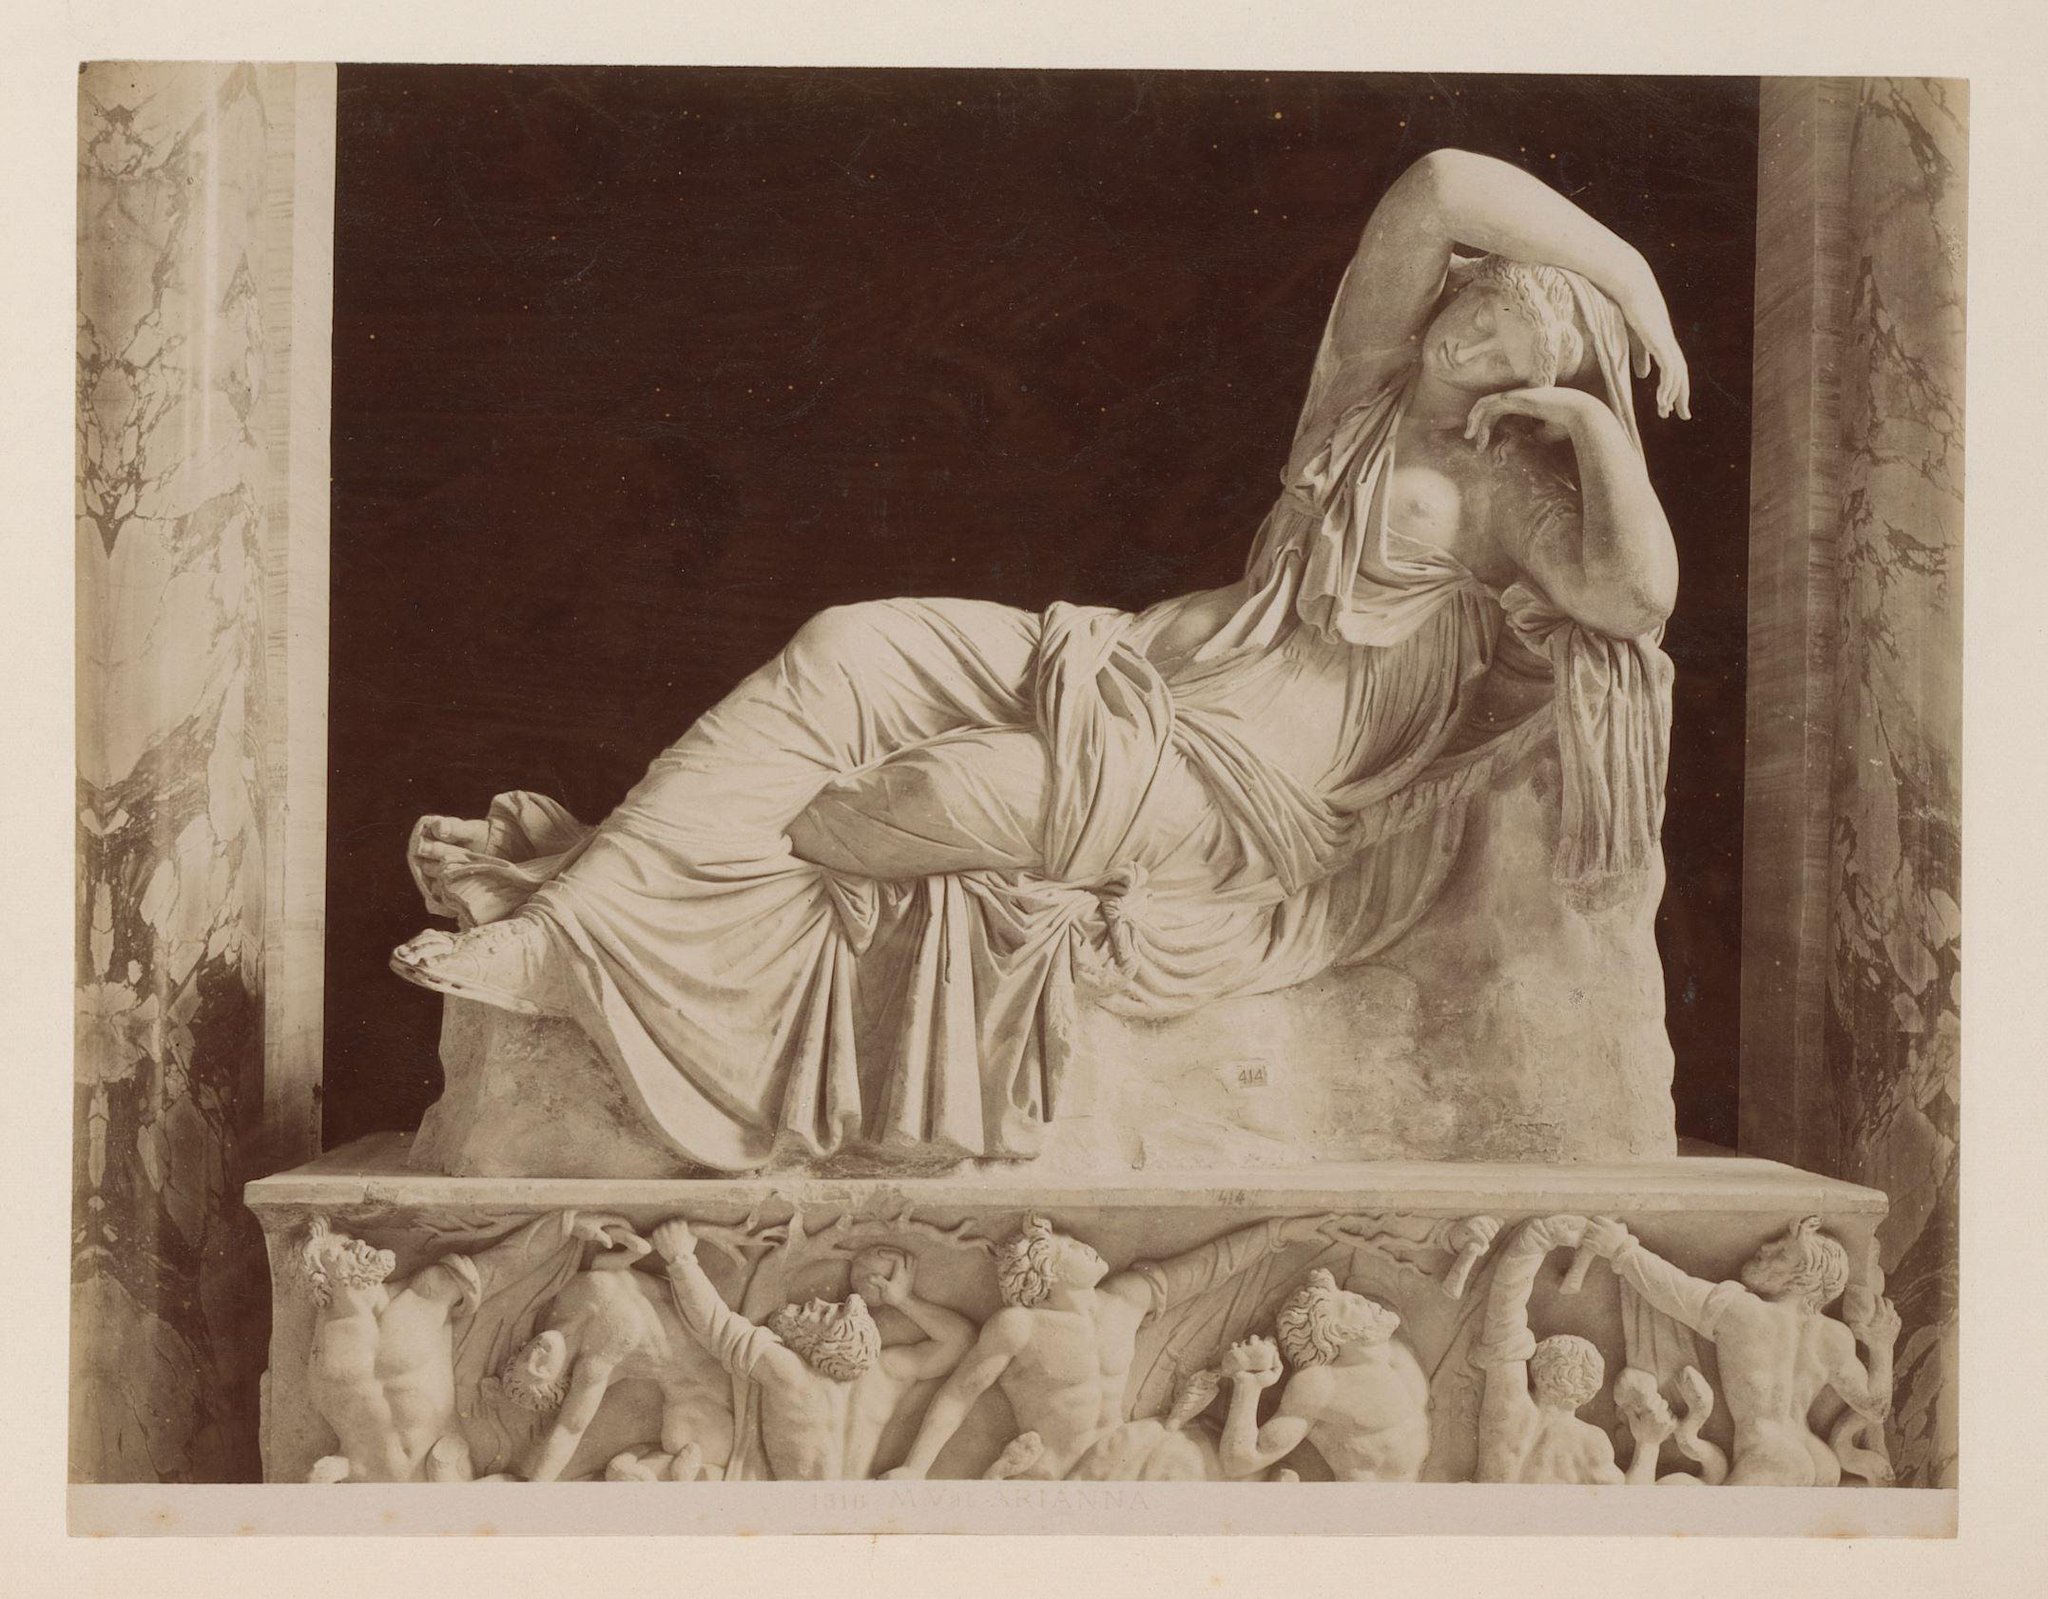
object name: album leaf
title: Sculptuur van slapende Ariadne, Vaticaan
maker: james anderson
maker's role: fotograaf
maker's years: 1813-1877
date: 1857-1875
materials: paper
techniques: albumen print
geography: vatican museums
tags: (story of) ariadne, piece of sculpture, reproduction of a piece of sculpture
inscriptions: inscription: ‘1316 M. Vat. Arianna’